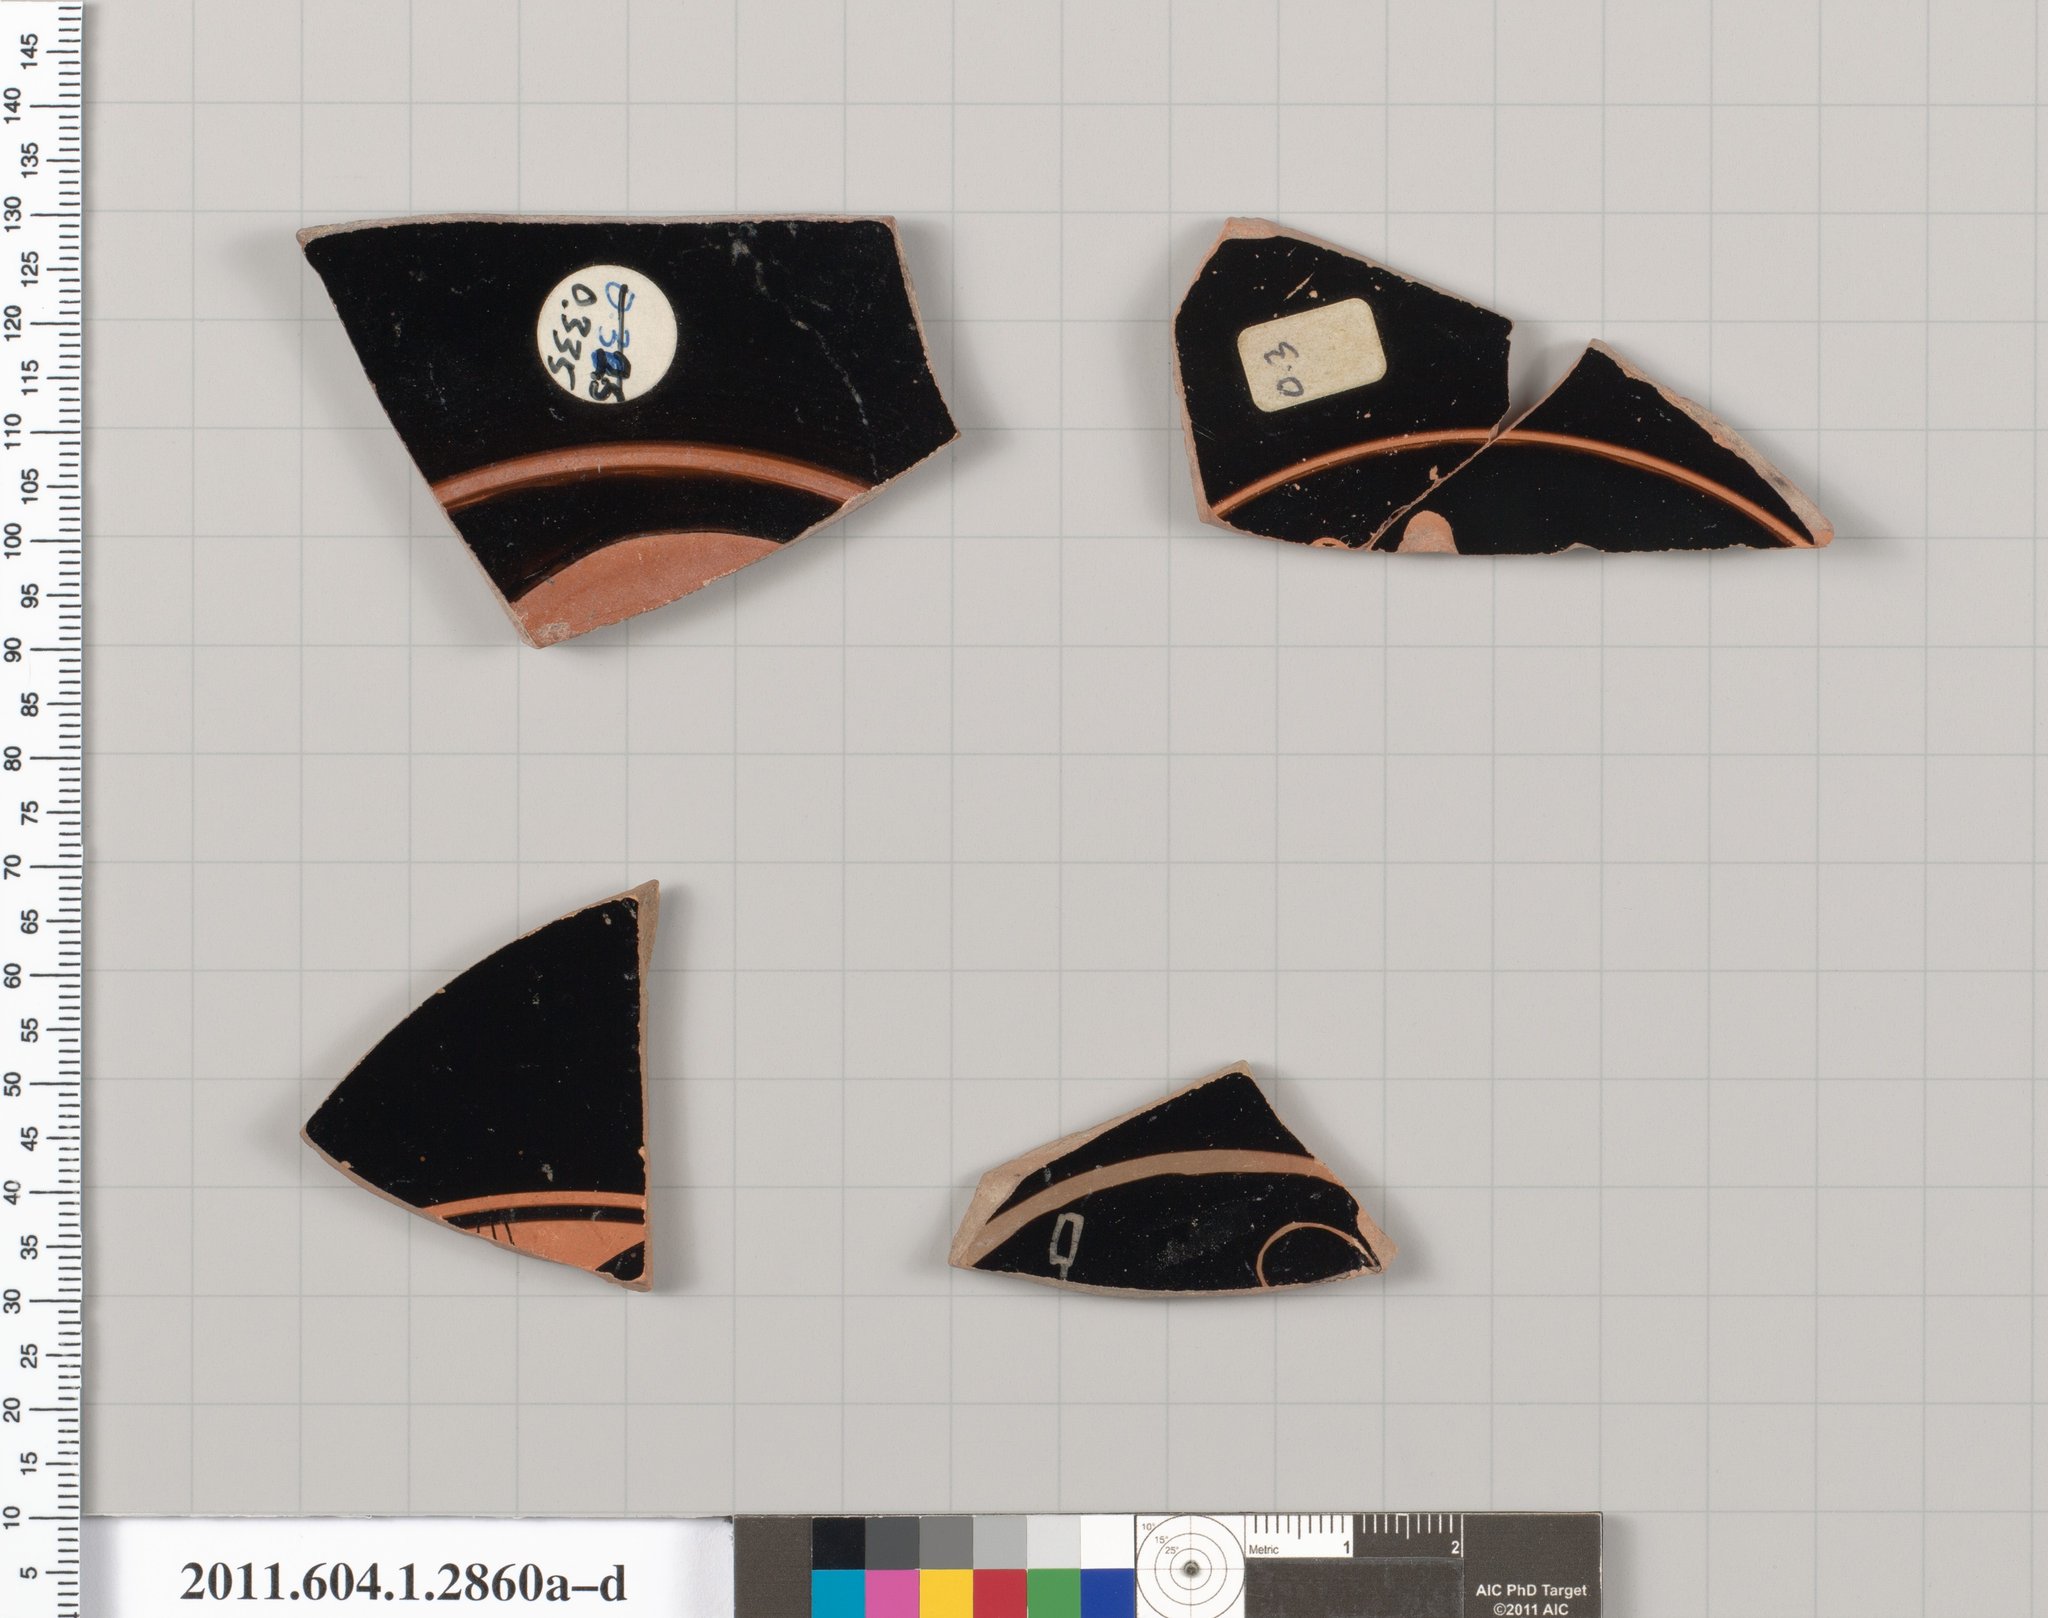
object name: kylix fragment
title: Terracotta fragments of kylikes (drinking cups)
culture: greek, attic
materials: terracotta